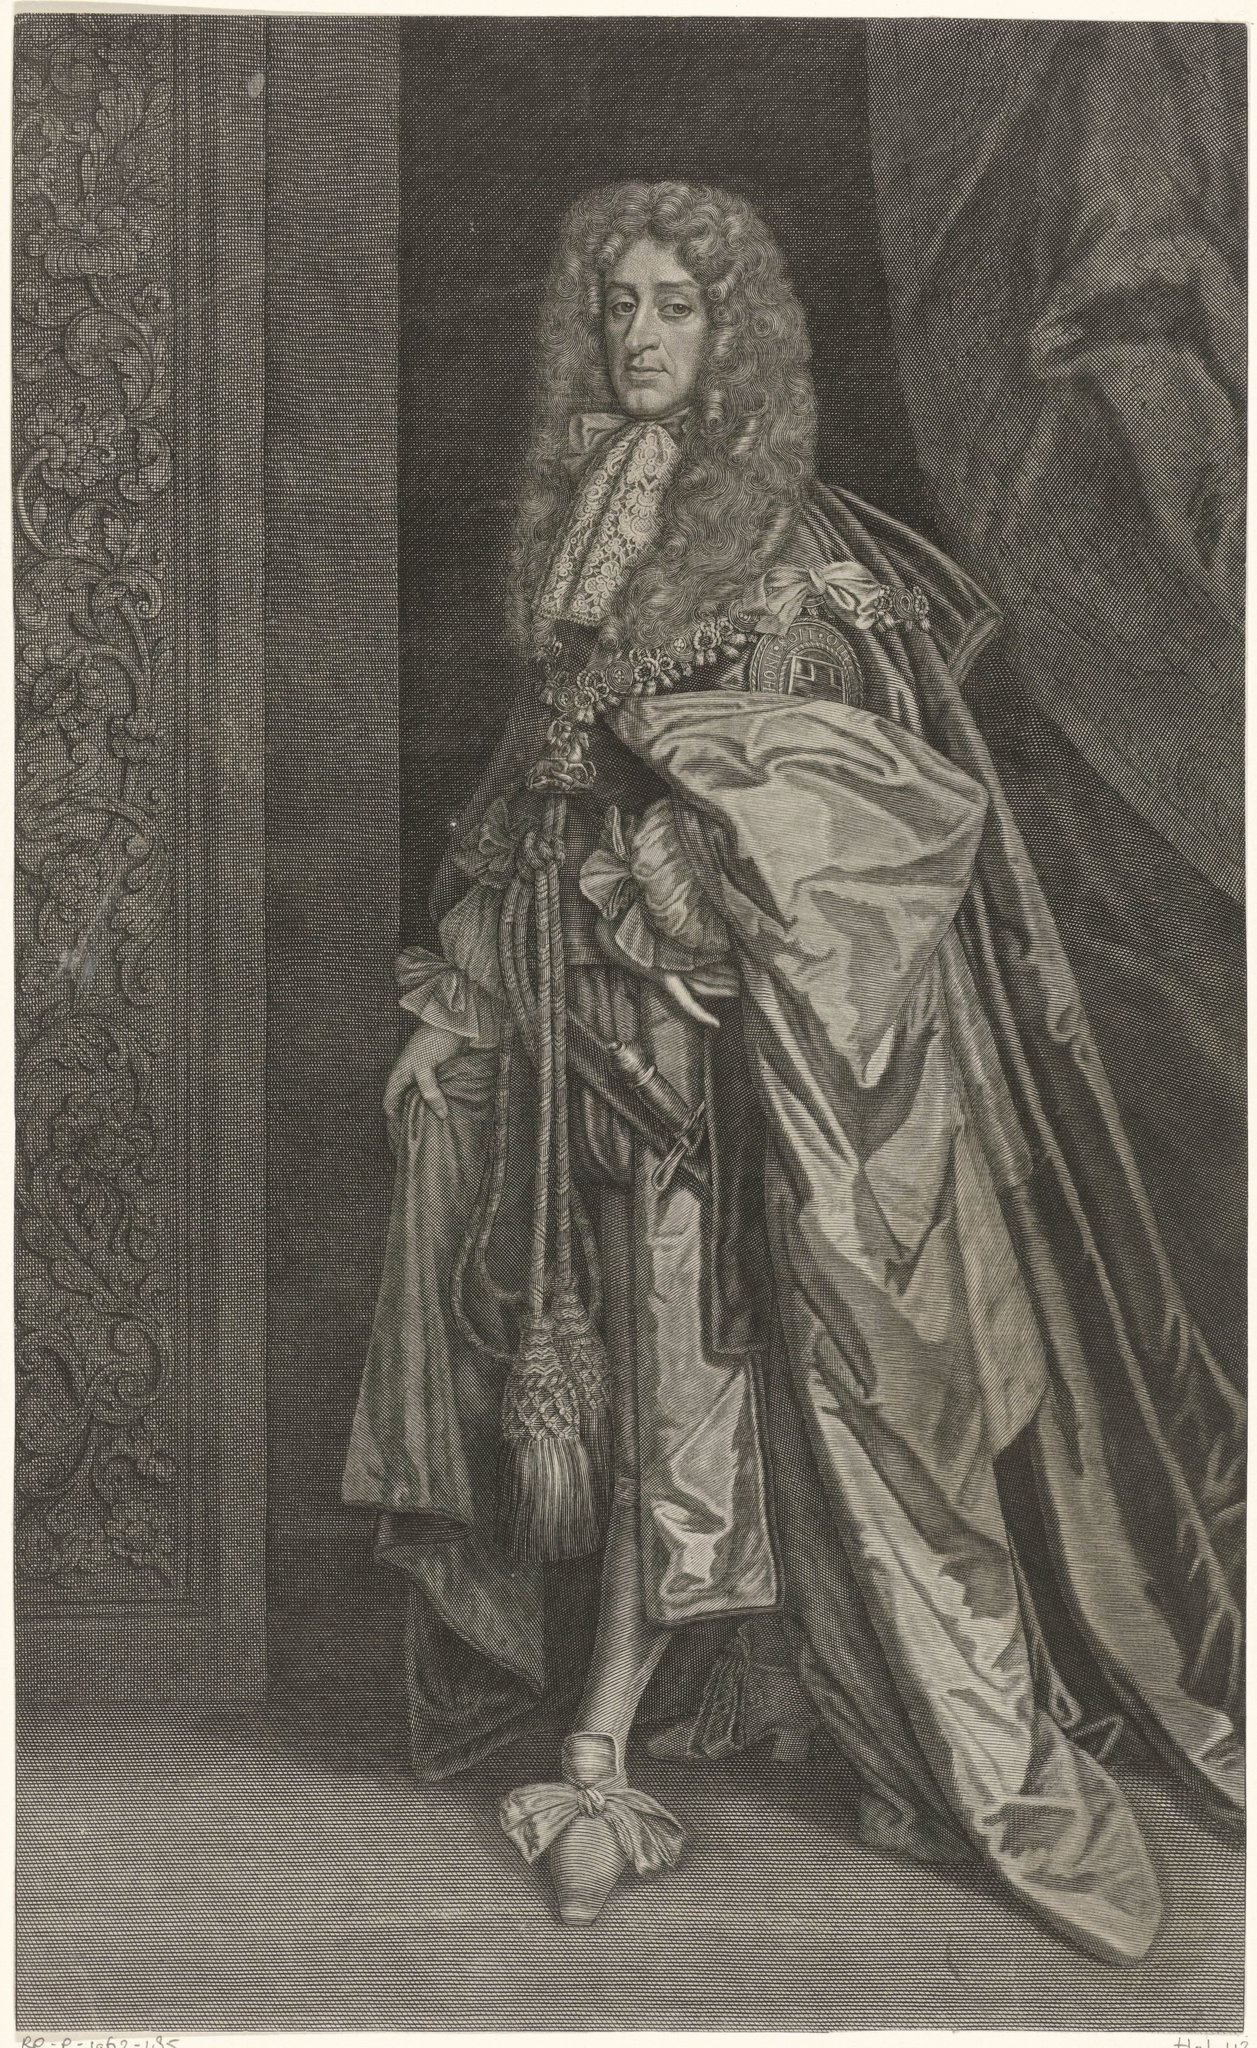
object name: print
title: Portret van koning Jacobus II van Engeland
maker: david loggan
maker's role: print maker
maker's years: 1633-1692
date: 1643-1692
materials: paper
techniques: engraving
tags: jacobus ii (koning van engeland en schotland)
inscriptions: collector's mark: Lugt 2228, collector's mark: Lugt 2760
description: Portret van Jacobus II, koning van Engeland en Schotland, ten voeten uit.